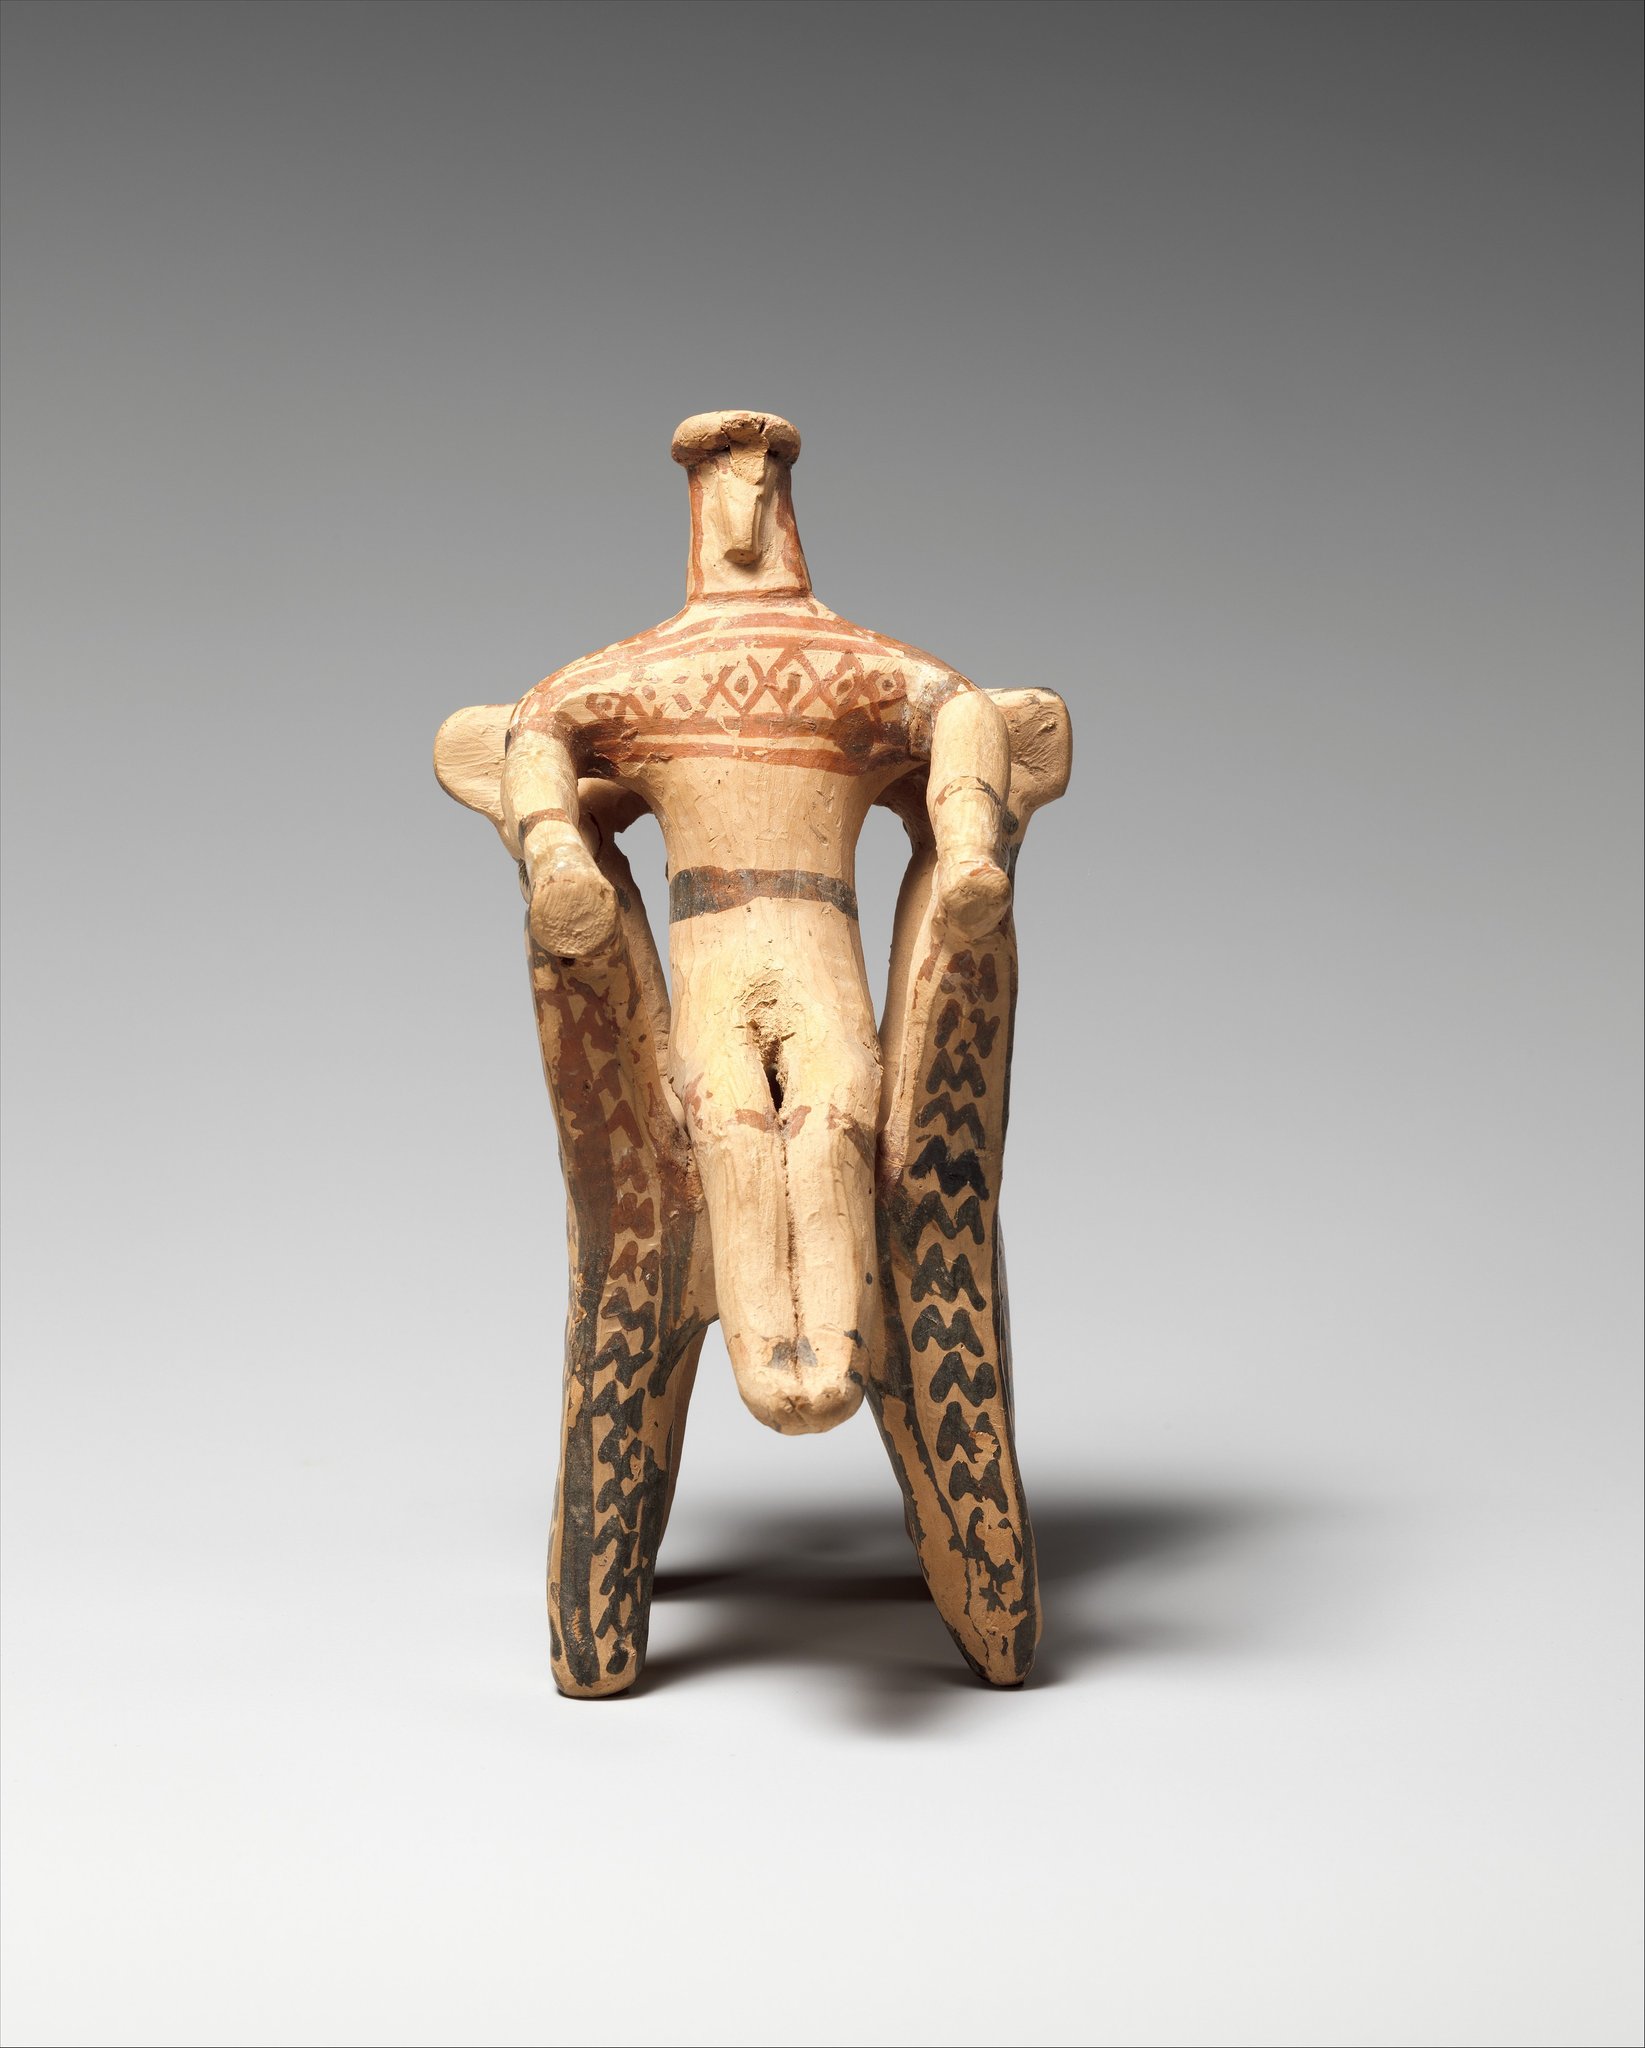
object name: statuette of a figure in a chair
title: Terracotta figure in an armchair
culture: greek, attic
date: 800-701 BCE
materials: terracotta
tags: human figures,chairs